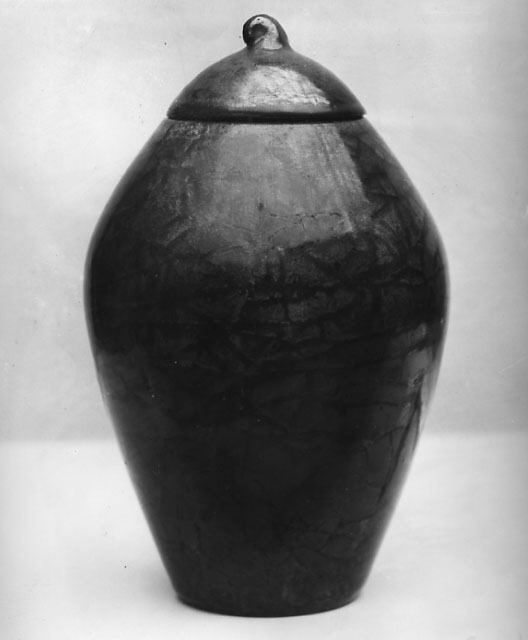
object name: vase with lid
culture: danish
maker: herman a. kähler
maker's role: designer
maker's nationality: danish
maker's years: 1846-1917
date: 1922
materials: ceramic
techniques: glazing